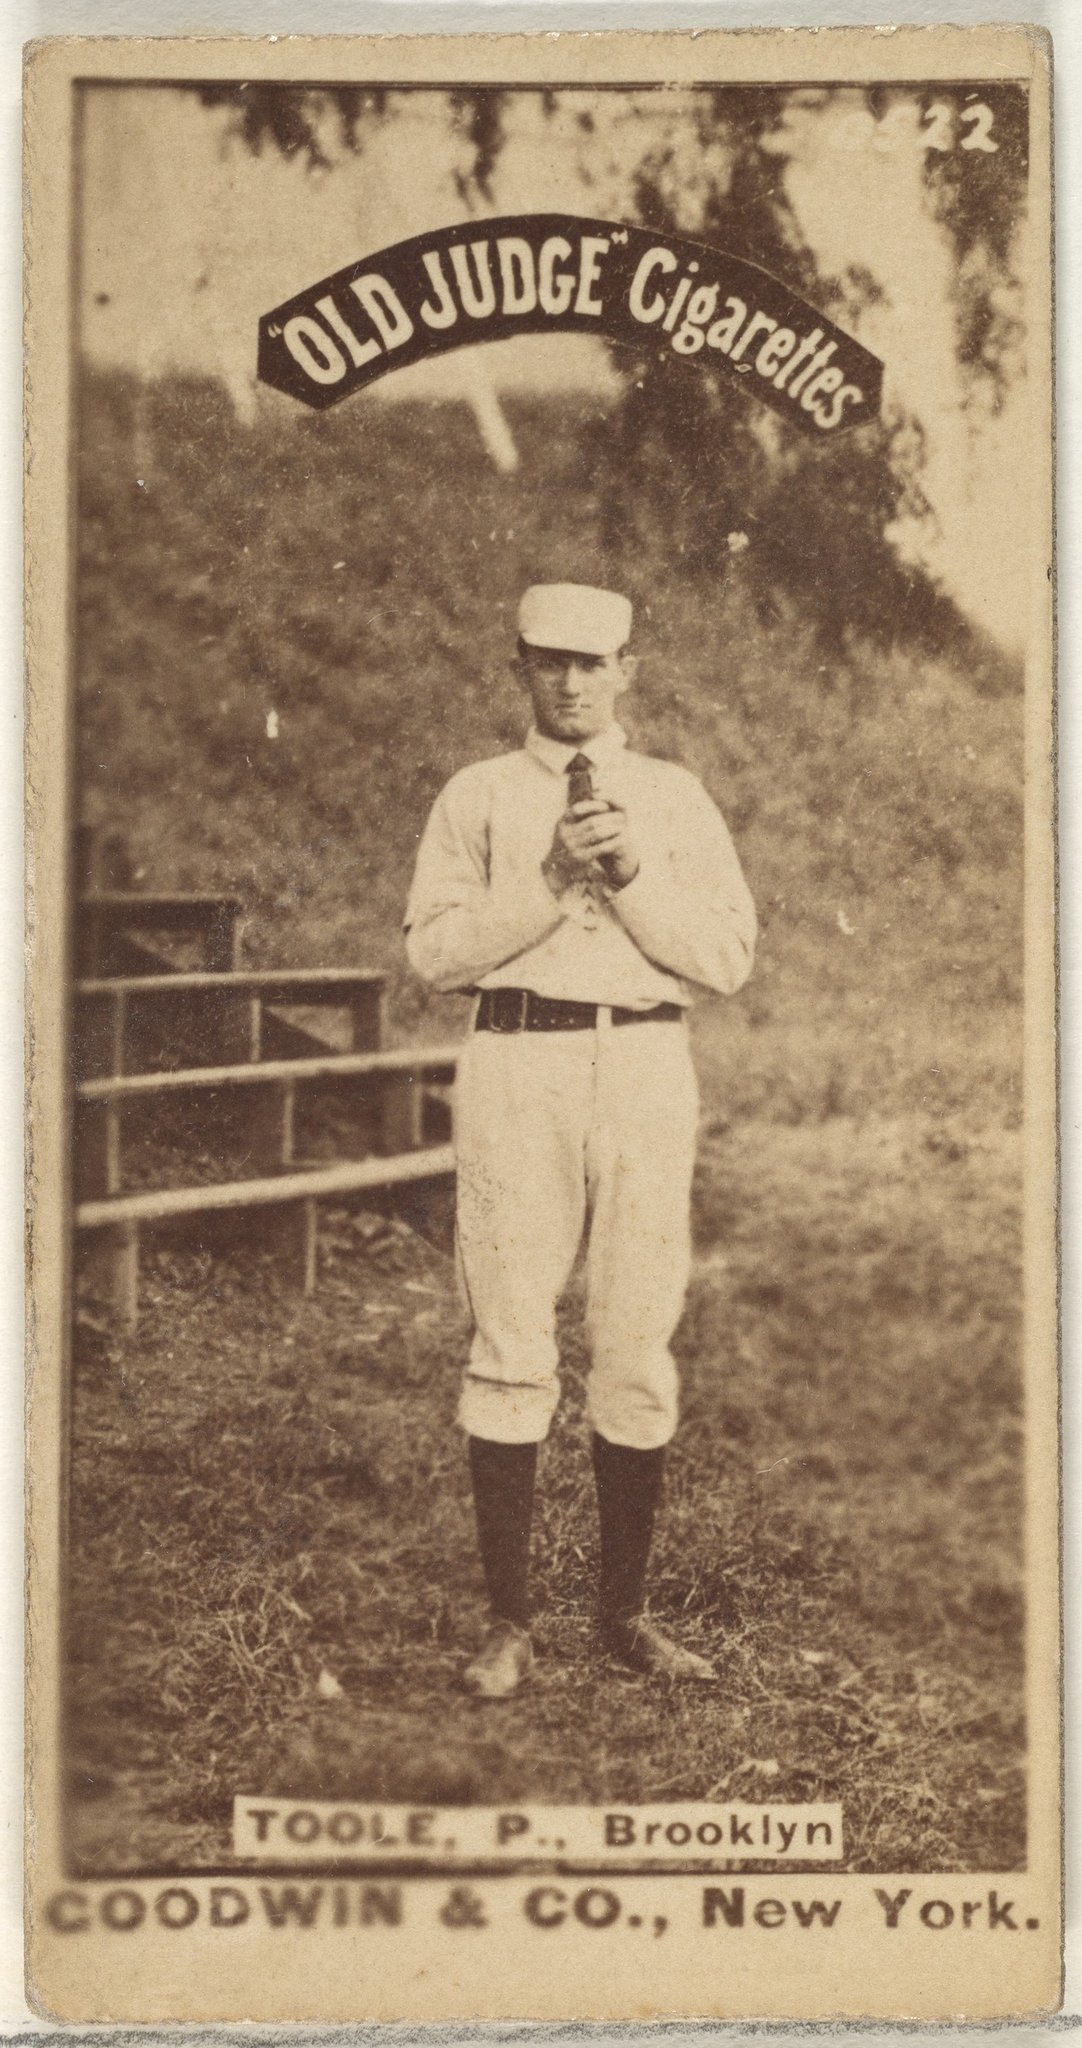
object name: baseball card, photograph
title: Toole, Pitcher, Brooklyn, from the Old Judge series (N172) for Old Judge Cigarettes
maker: goodwin & company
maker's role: publisher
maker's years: 1850-1950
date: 1887-1890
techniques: albumen silver print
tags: men,portraits,baseball,athletes